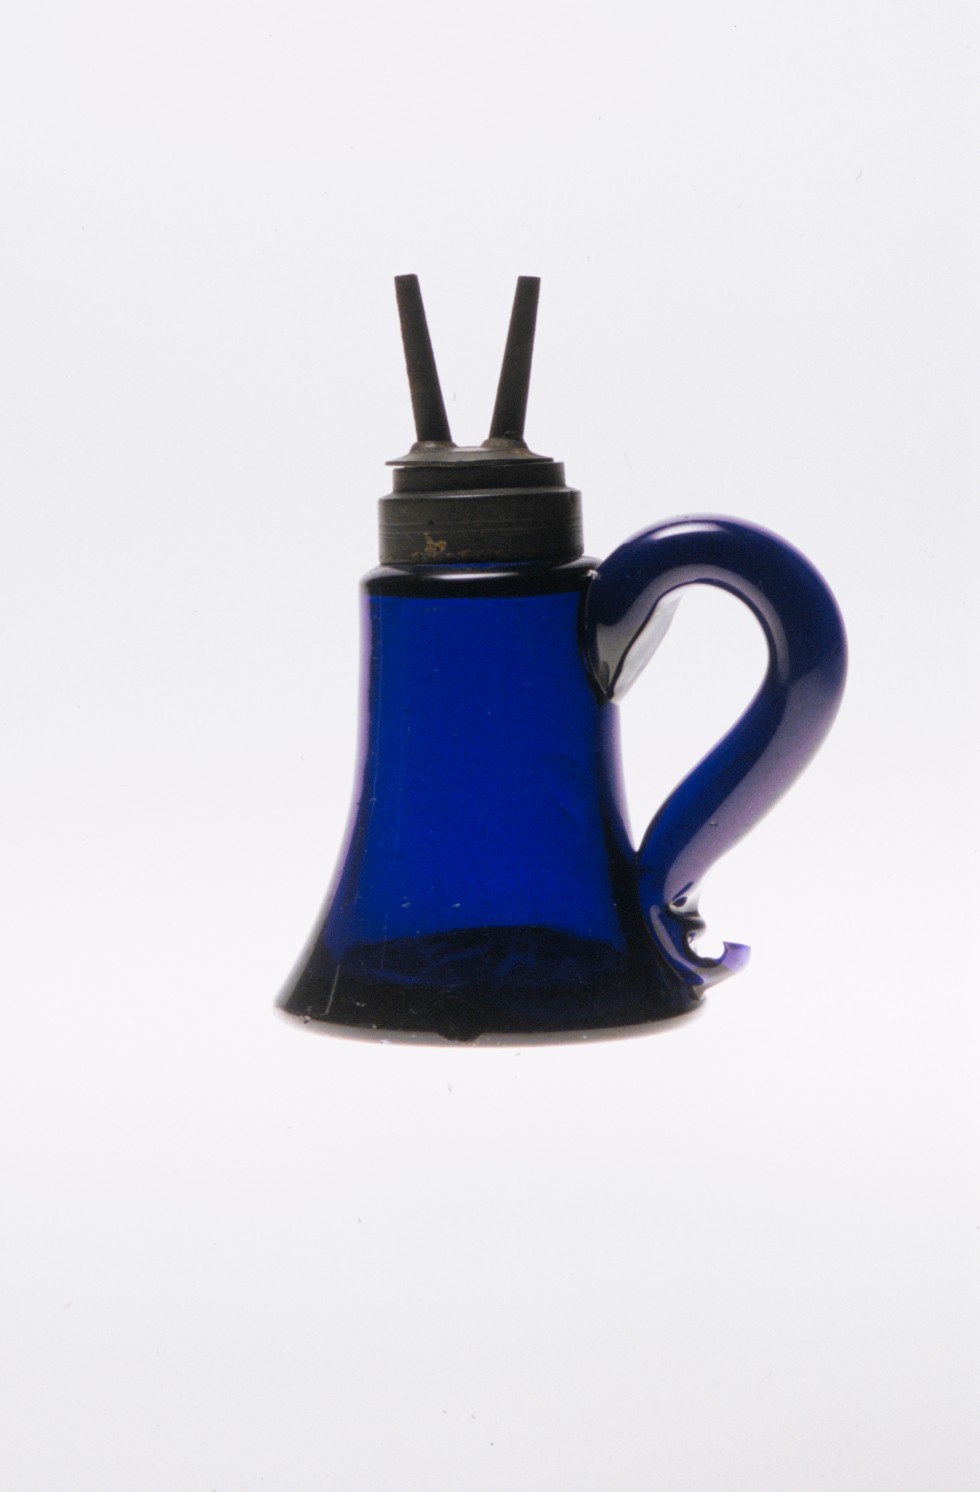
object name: whale oil lamp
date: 1830-1860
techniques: glassblowing